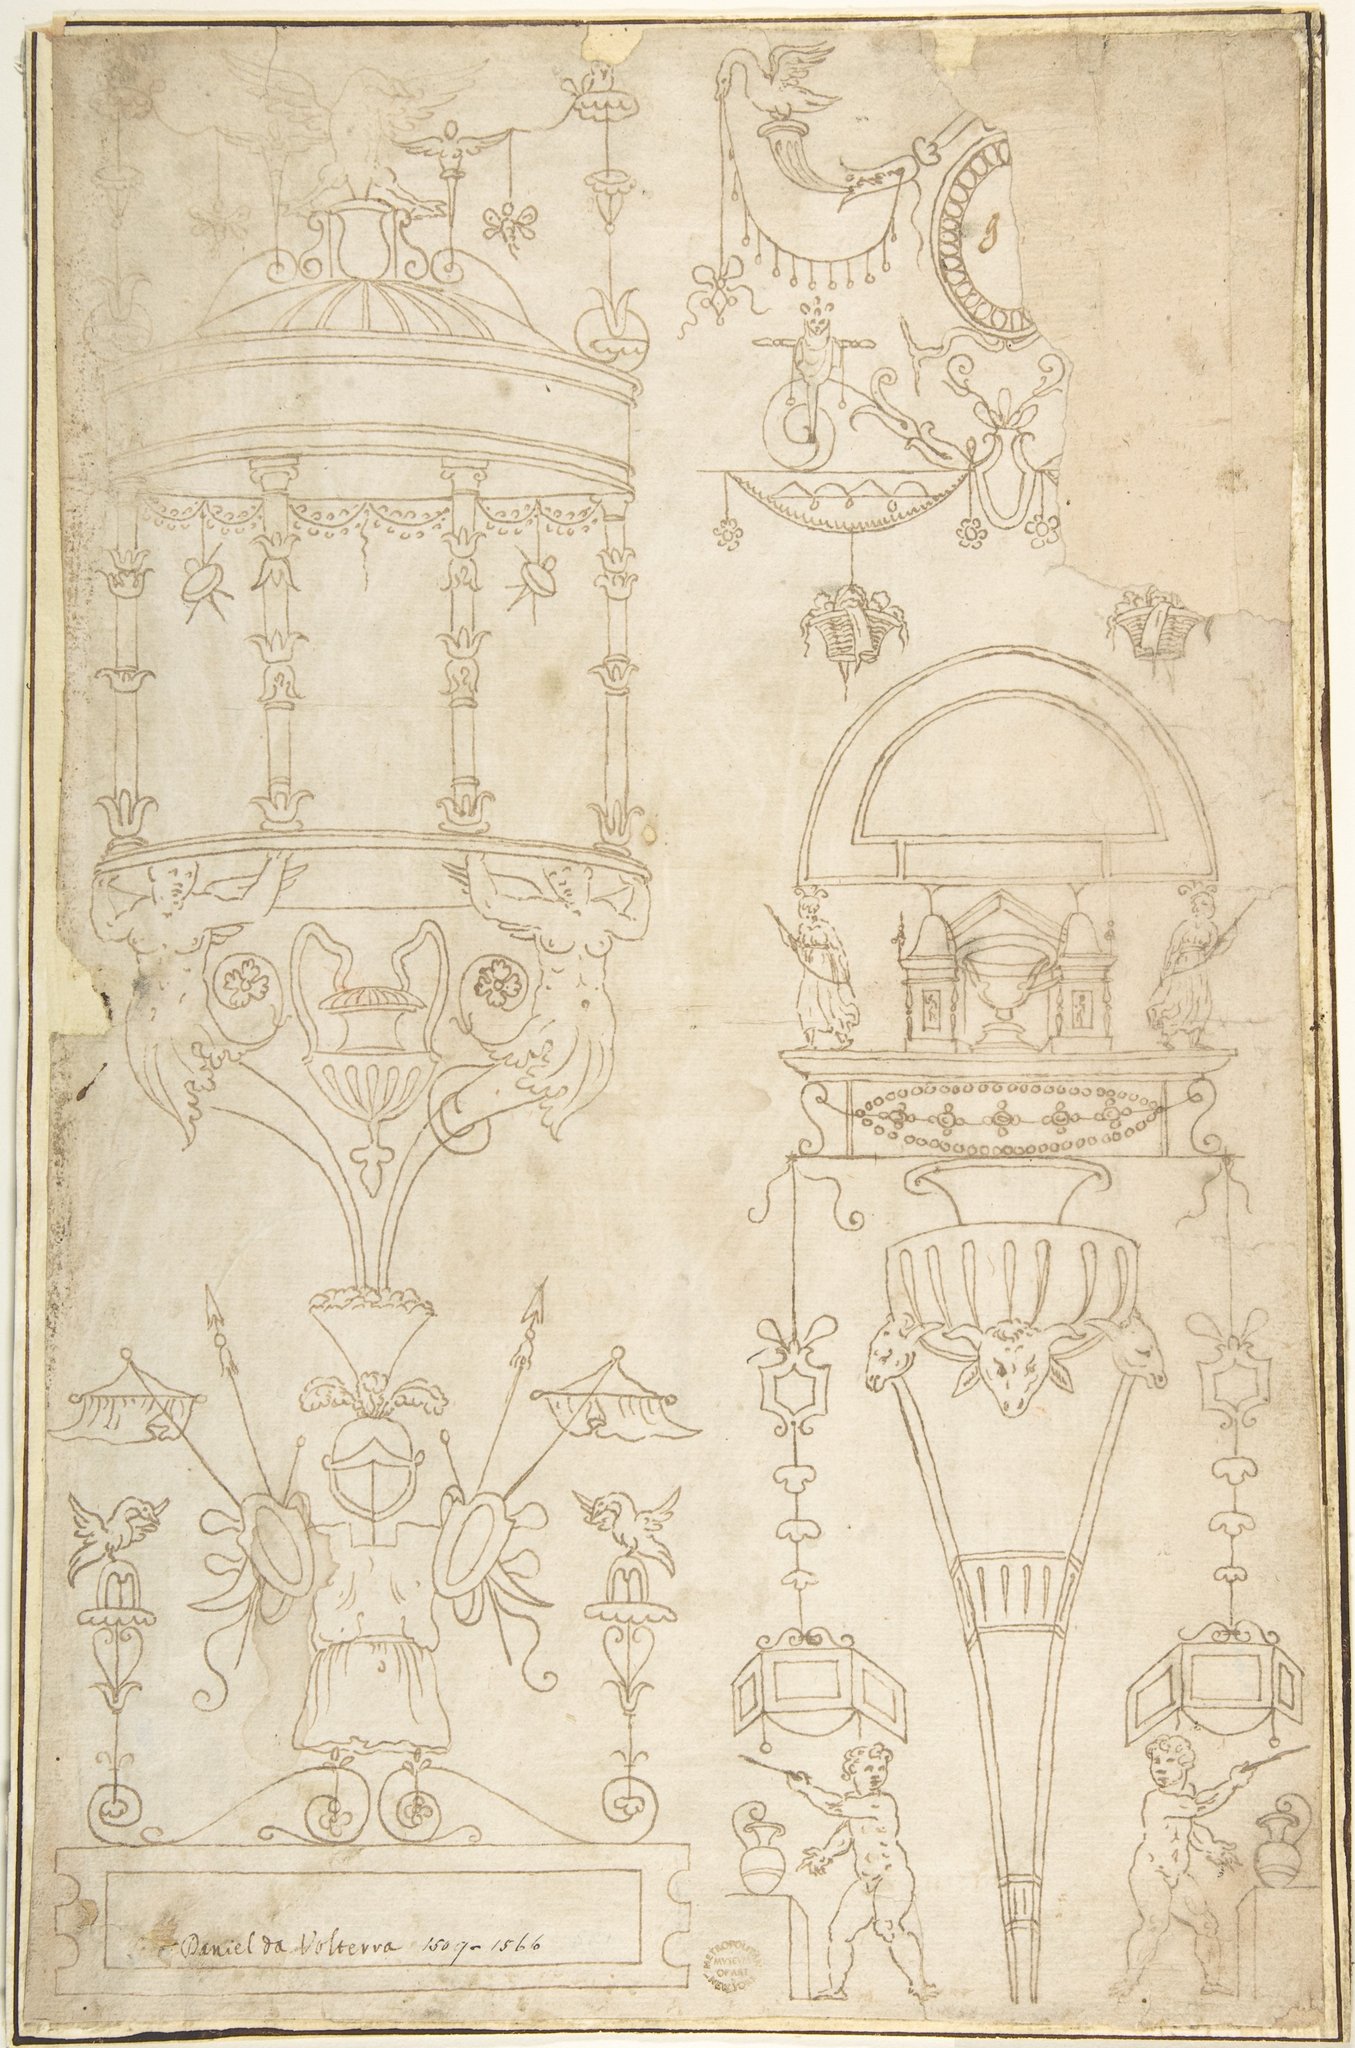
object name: drawing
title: Wall Decoration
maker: anonymous, italian, 16th century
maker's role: artist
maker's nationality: italian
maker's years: 1550-1600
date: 1501-1600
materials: ink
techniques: pen